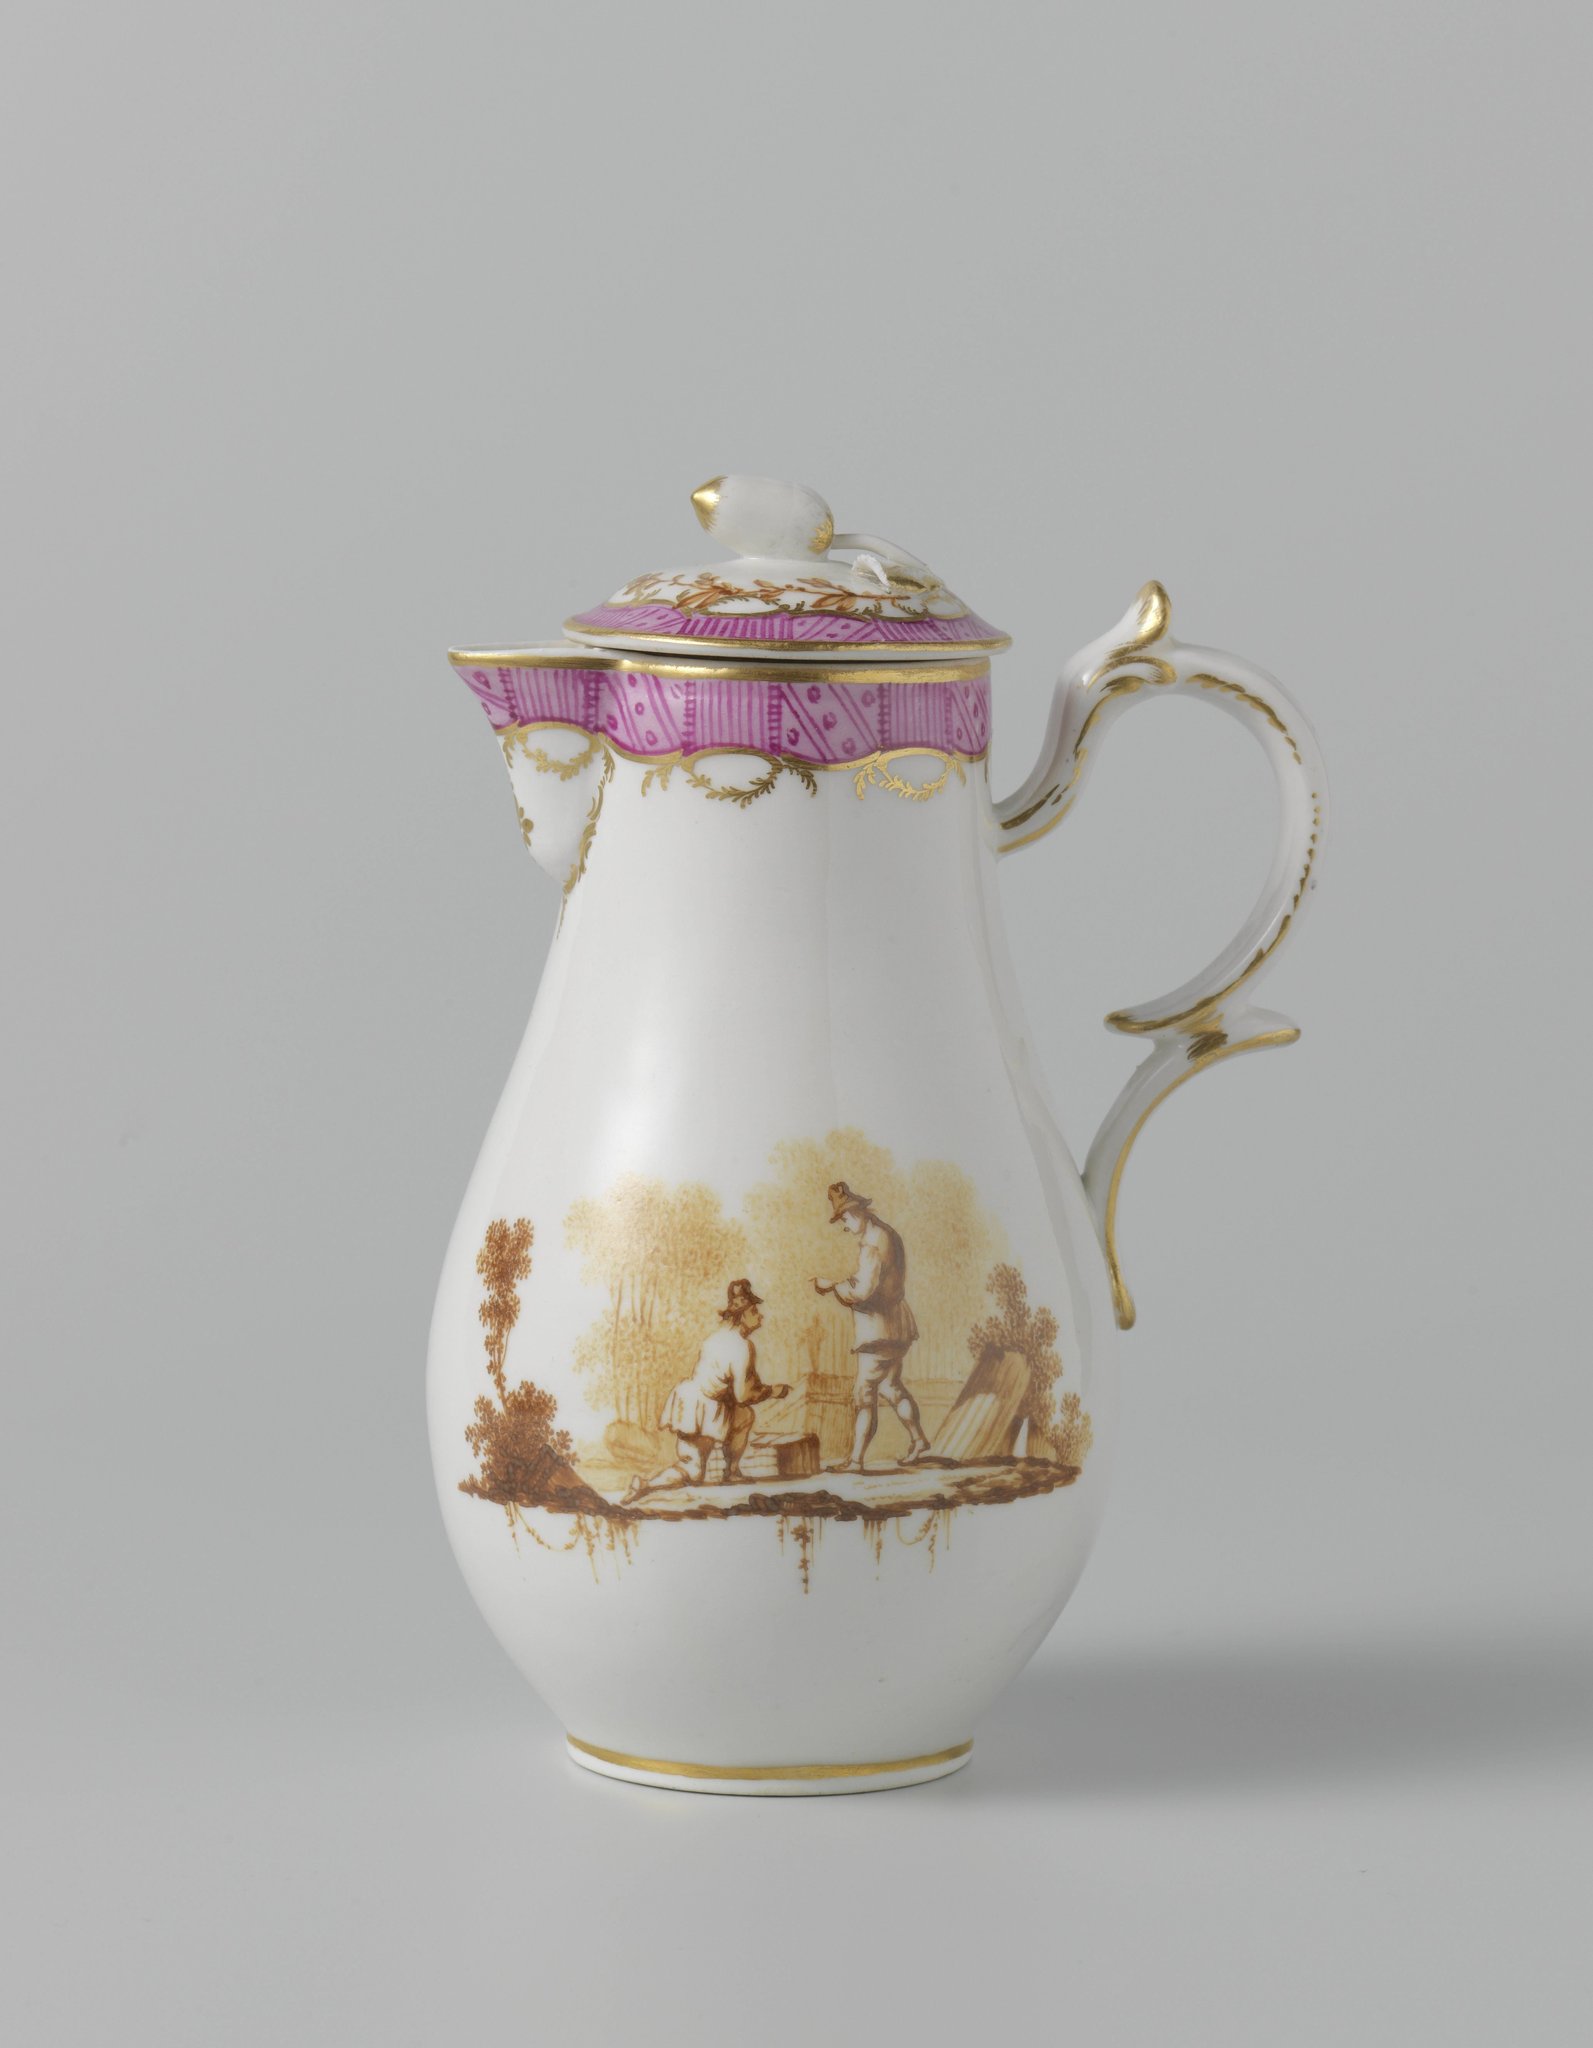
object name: milk jug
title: Tea service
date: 1774-1778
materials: porcelain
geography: loosdrecht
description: Tea services represented a significant part of the production of the Loosdrecht porcelain factory. On display here are a teapot, milk jug and sugar bowl along with other less familiar parts of a tea service, such as a slop bowl, which is used to rinse and warm the cups between two ‘courses’, and a drip catcher (pattipan), which catches the drips from the spout of the teapot.